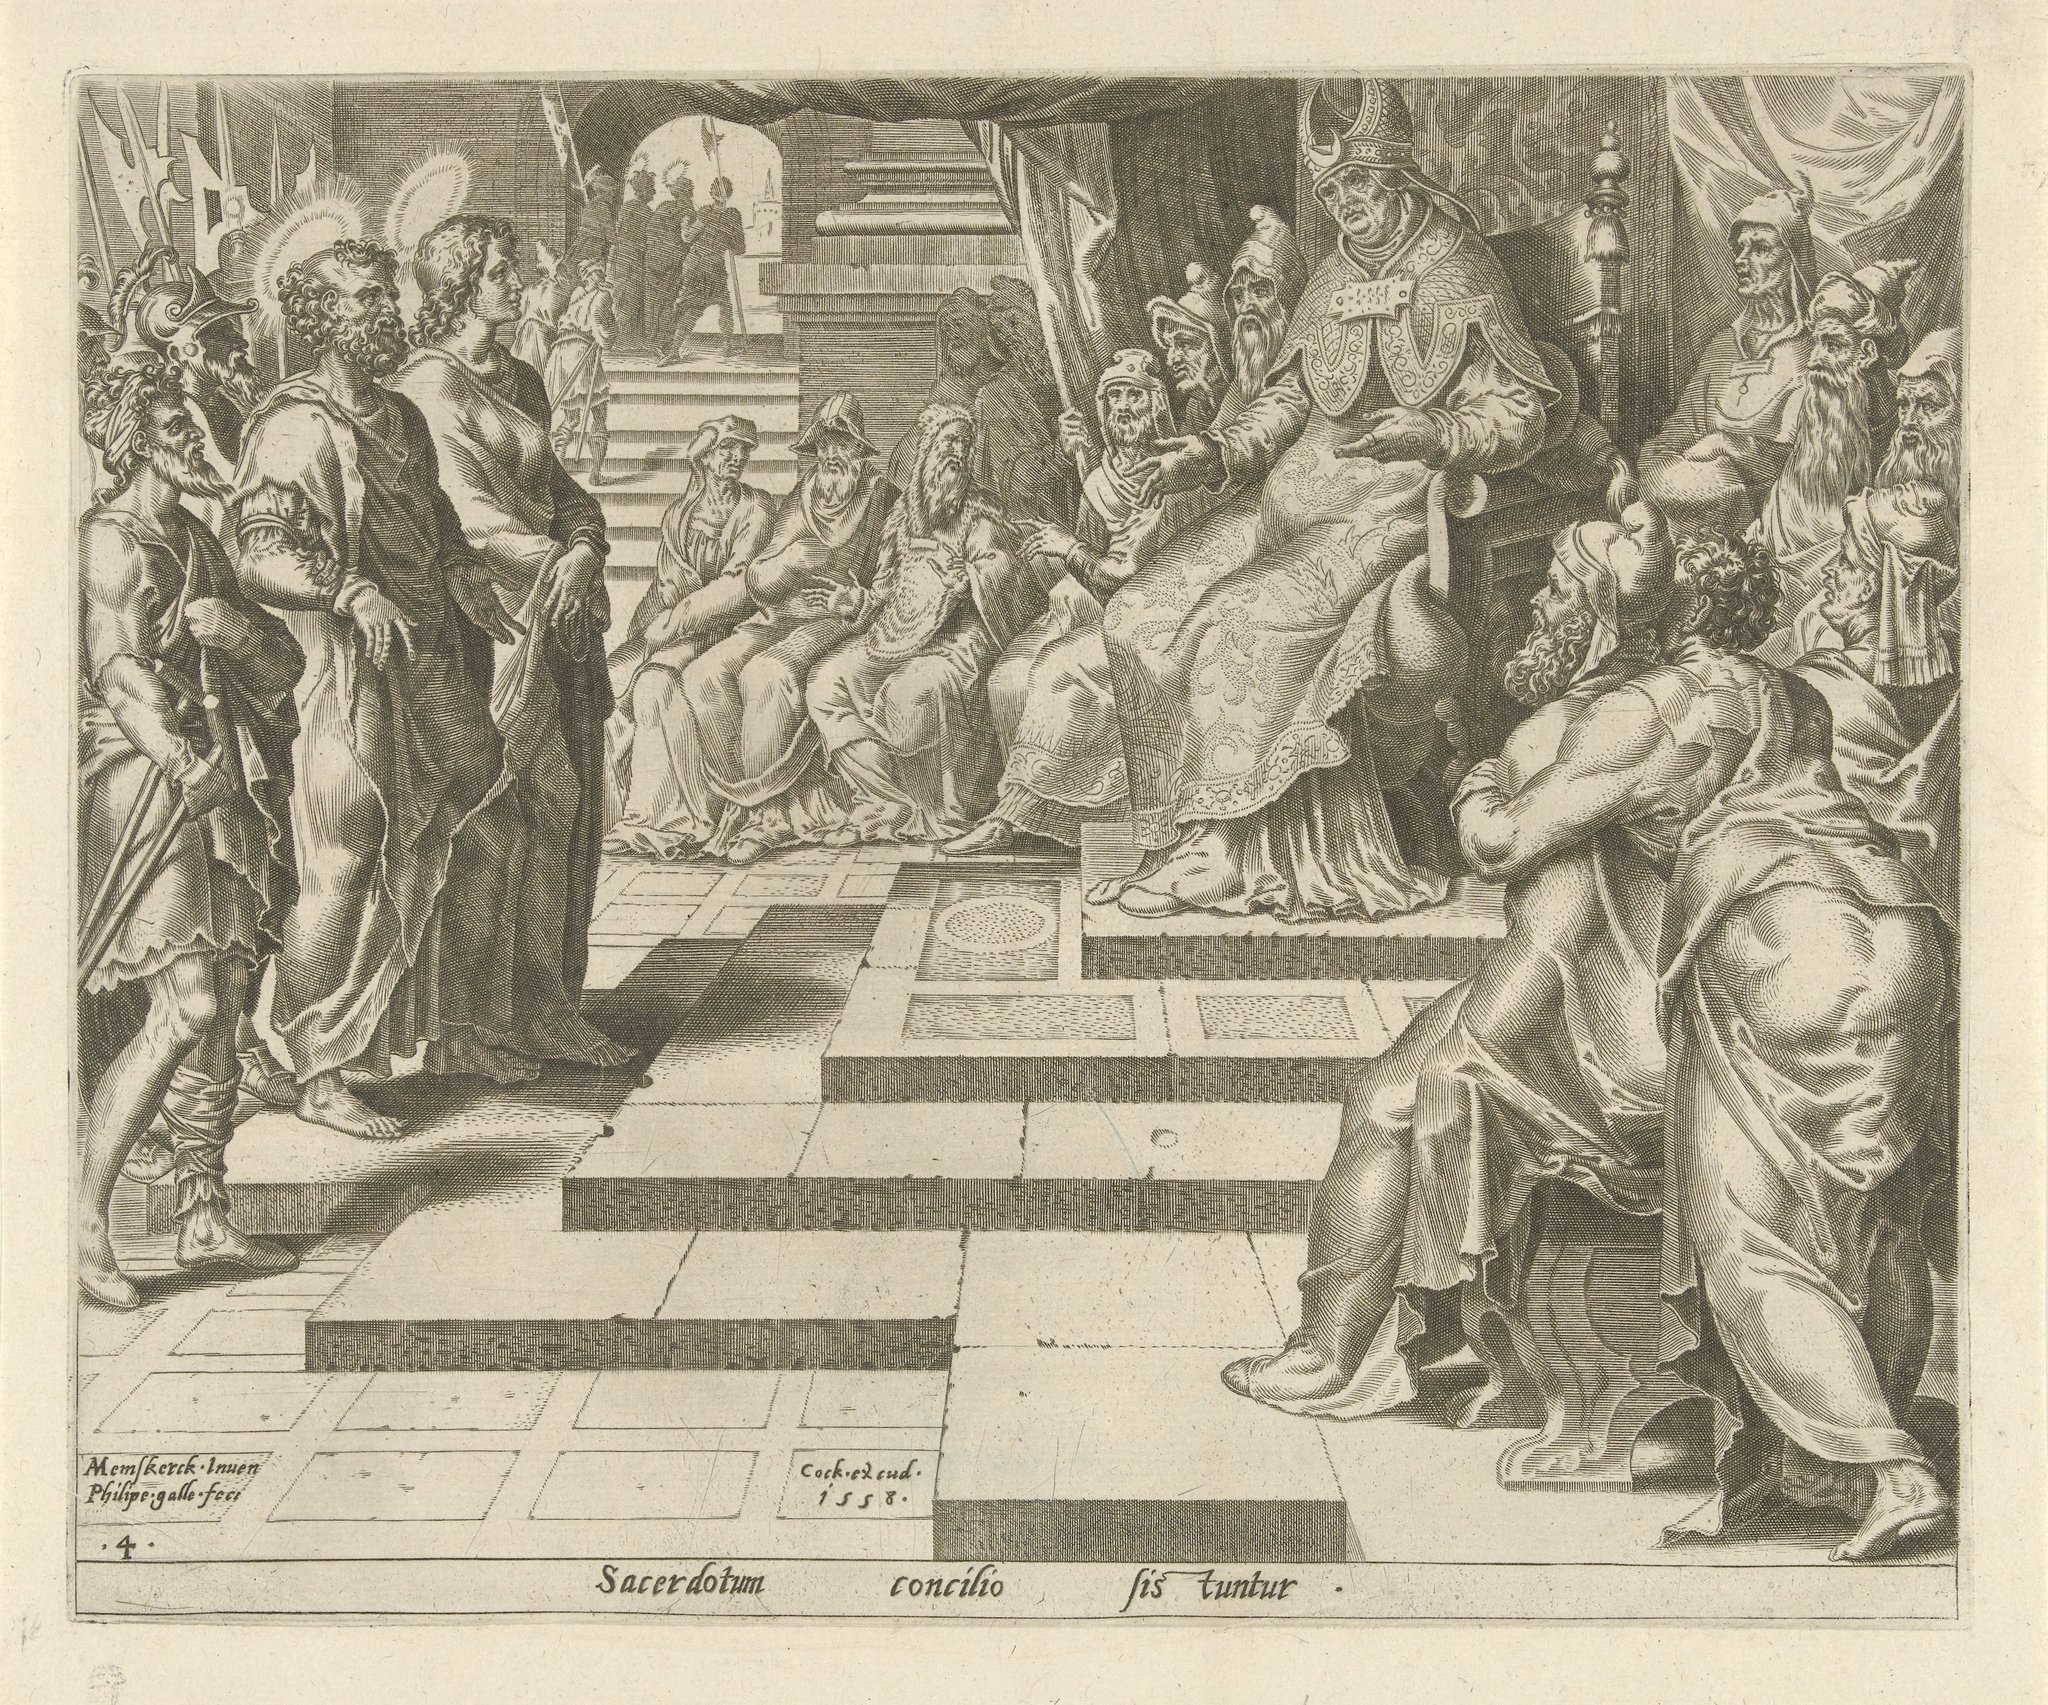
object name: print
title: Petrus en Johannes voor de hogepriester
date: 1558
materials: paper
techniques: engraving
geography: antwerp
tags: the high priest and sadducees have peter and the apostles put in prison (acts 5:17-42)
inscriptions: collector's mark: Lugt 2228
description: Petrus en Johannes worden voorgeleidt voor het gerecht, bestaande uit de hogepriester, schriftgeleerden en ouderlingen.